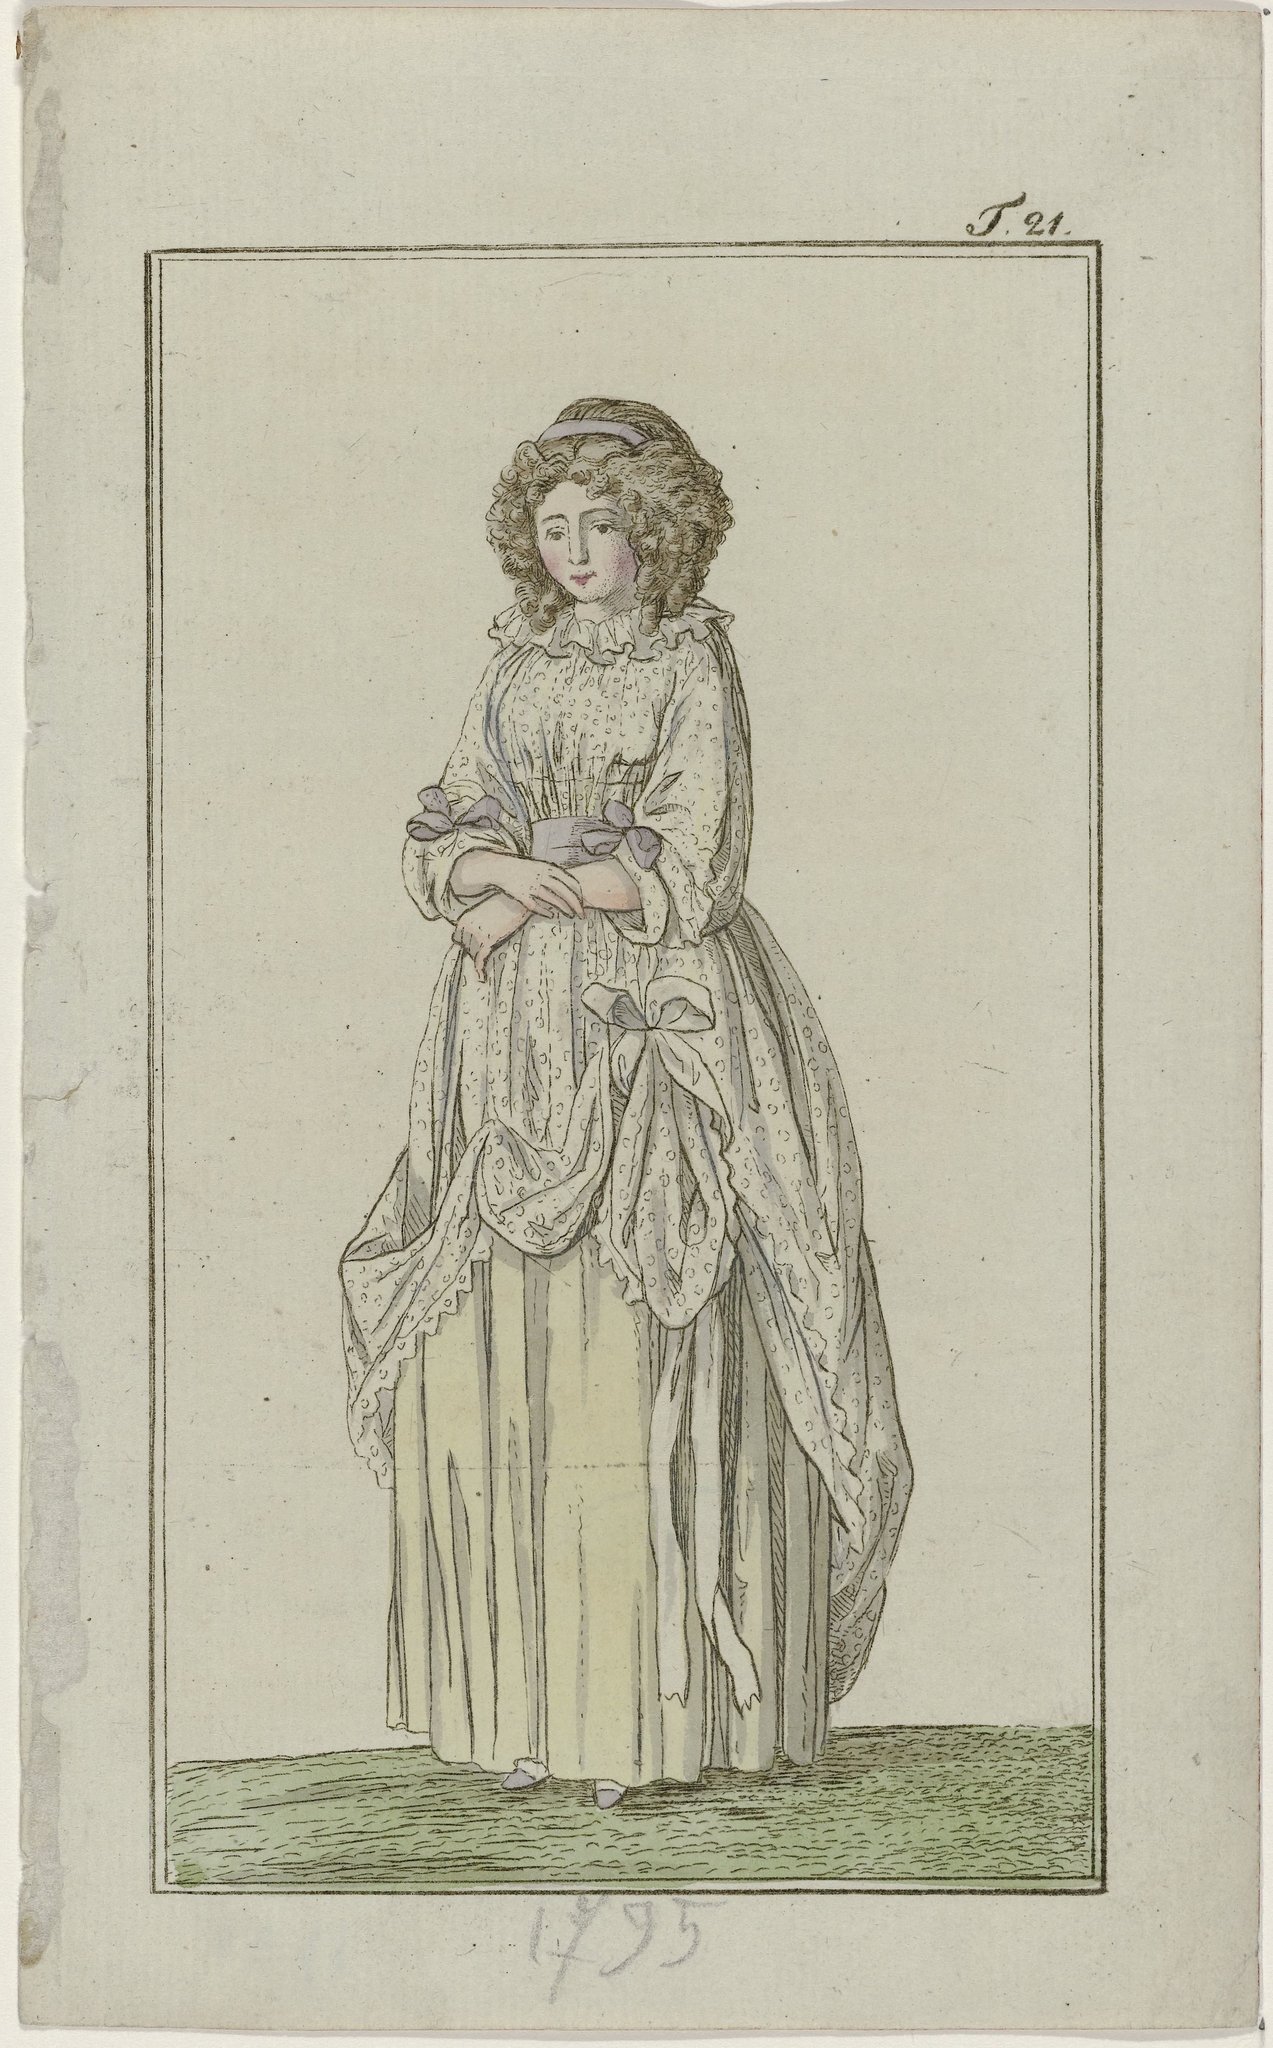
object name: fashion print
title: Journal des Luxus und der Moden, 1795, T 21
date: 1795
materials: paper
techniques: etching, hand coloring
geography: weimar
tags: bow (ornamental part of clothing) (+ women's clothes), diadem, tiara (+ women's clothes), fashion plates, shoes, sandals (+ women's clothes), skirt (+ women's clothes), dress, gown (+ women's clothes)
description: Vrouw in een gestippelde japon met een geplooide kraag en halflange wijde mouwen met strikken. De rok is aan de voorzijde opgehouden en voorzien van een strik met twee afhangende linten, waaronder een onderrok te zien is. Accessoires: haarband, ceintuur, schoenen. Prent uit het modetijdschrift Journal des Luxus und der Moden, uitgegeven door Friedrich Justin Bertuch en Georg Melchior Kraus, Weimar, 1786-1826.